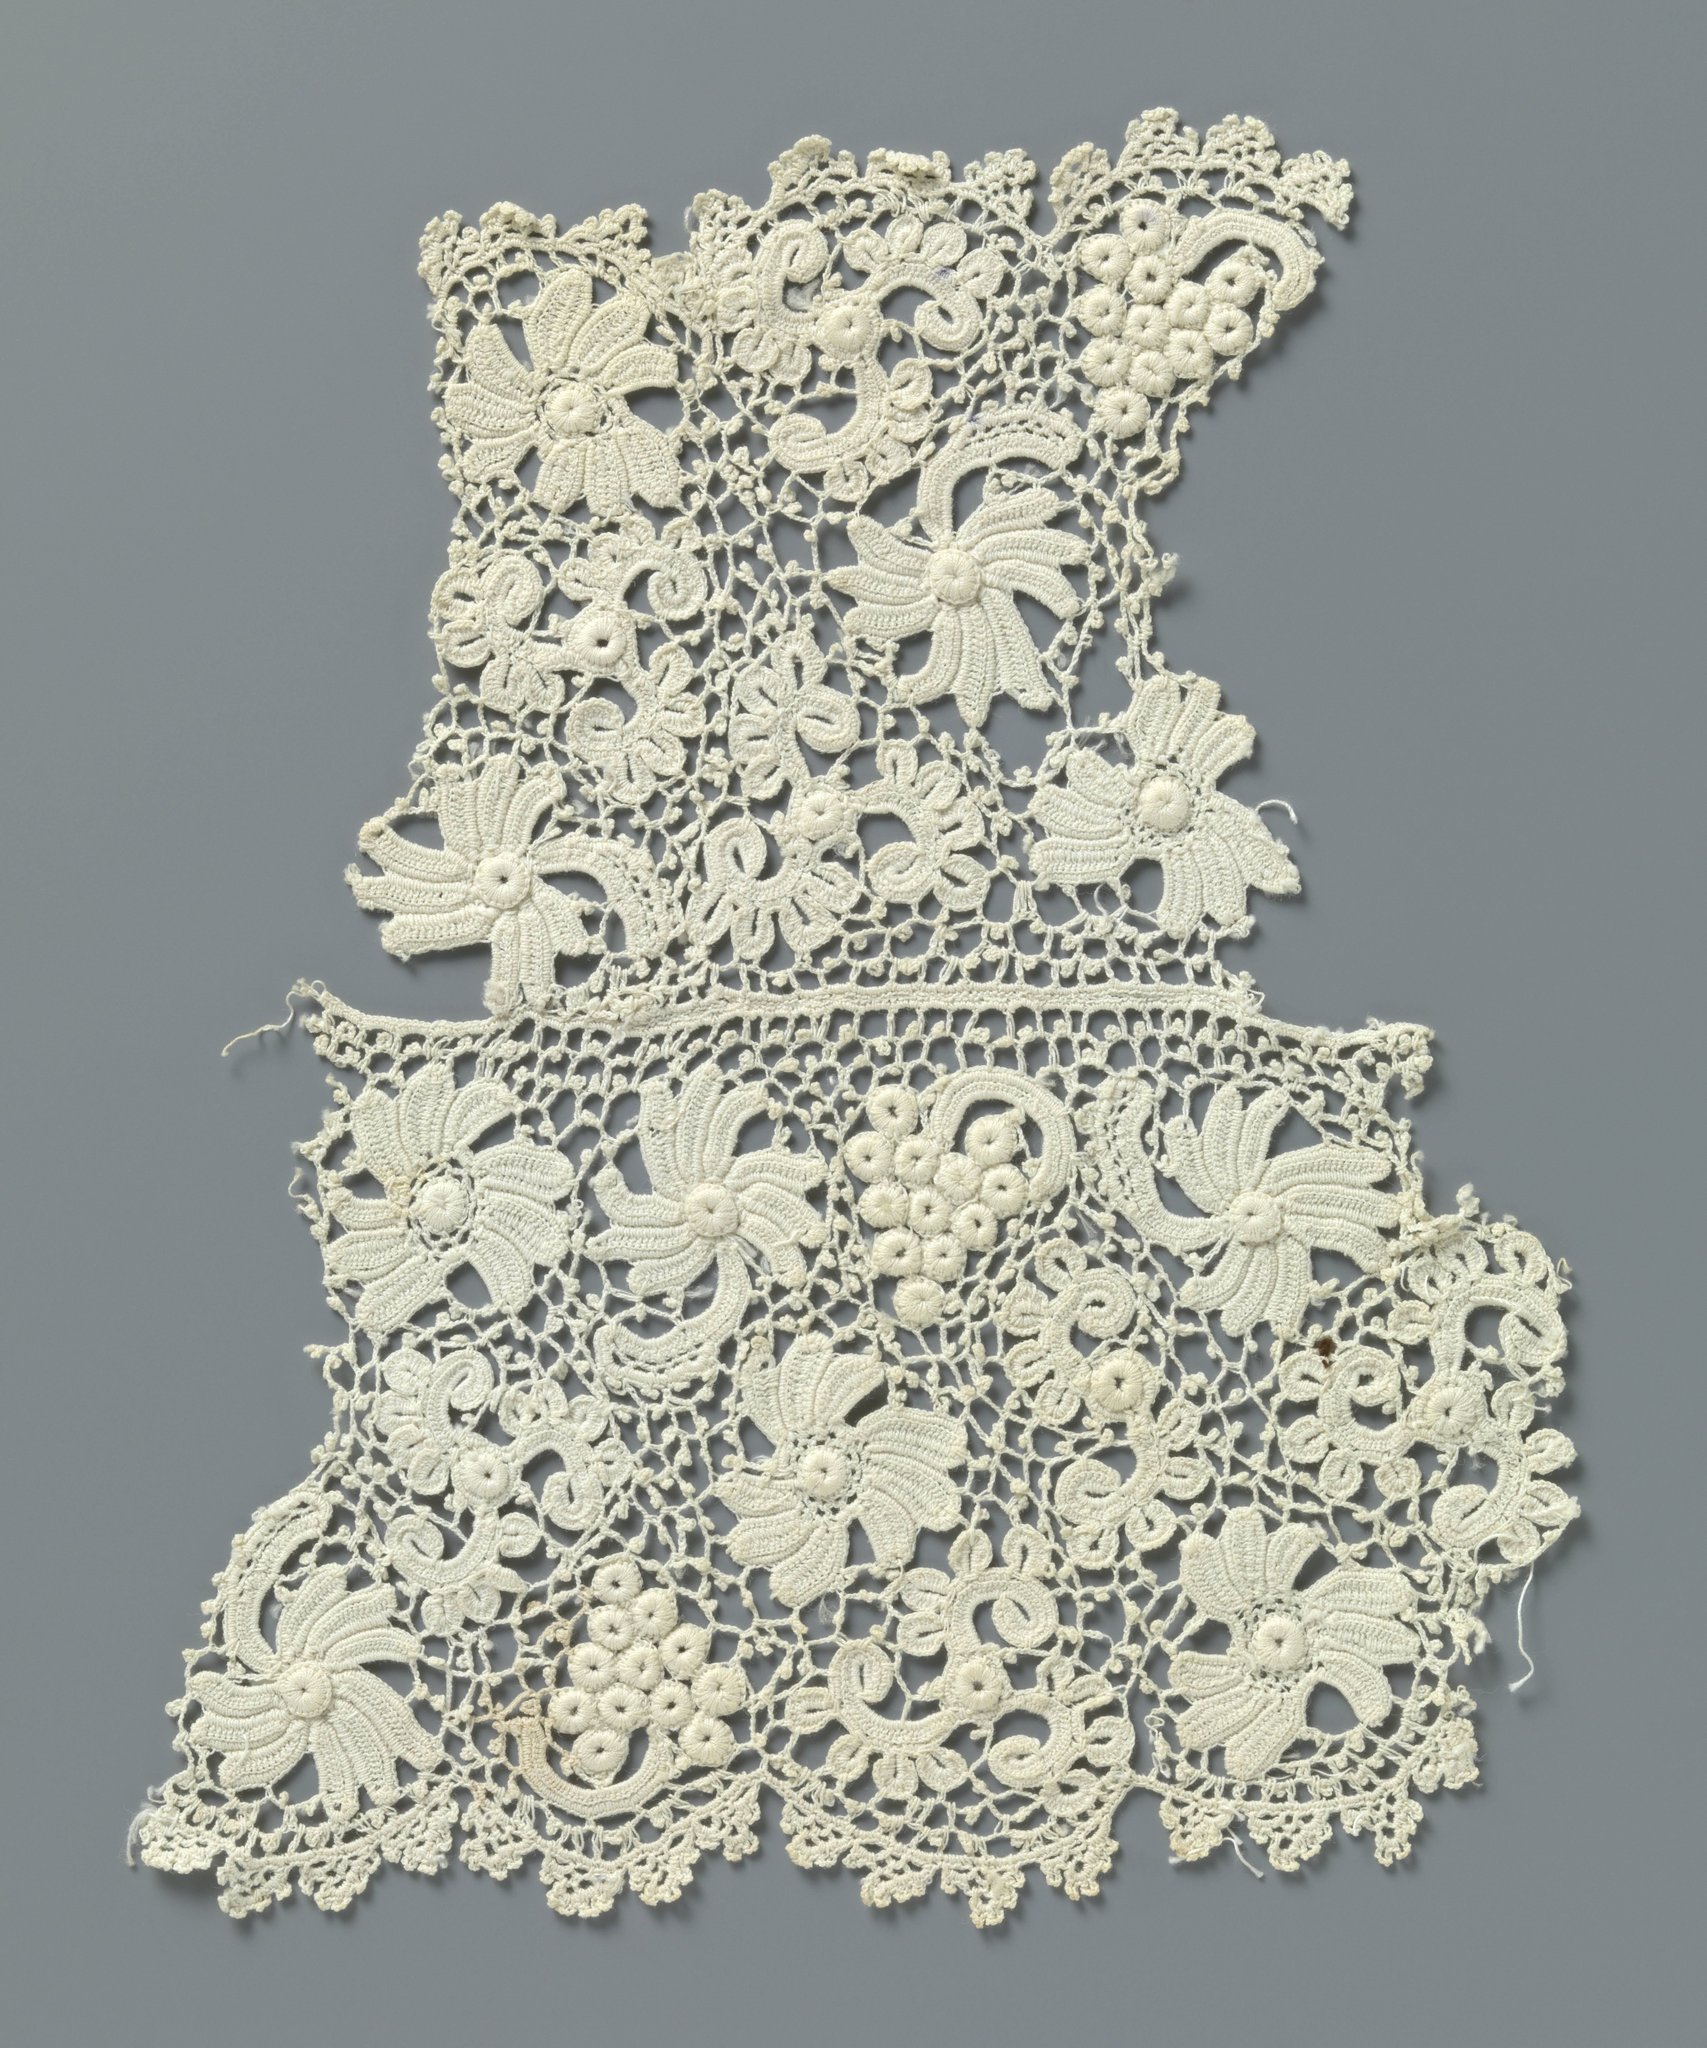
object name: strip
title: Dubbele strook gehaakte kant met bloemen en druiventros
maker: Anonymous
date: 1890-1909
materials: cotton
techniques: crocheted lace, irish crochet lace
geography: ireland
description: Het is een aanname dat deze Ierse gehaakte kant ook daadwerkelijk in Ierland is gemaakt. Ierse gehaakte kant kent zijn oorsprong rond 1760 en kwam vanaf 1840 in ontwikkeling. Aangezien volgens Martine Bruggeman (Kant in Europa) de Ierse haakindustrie aan het eind van de 19e eeuw gereorganiseerd werd en in populariteit groeide, is het hier beschreven stuk gedateerd rond 1890, tot 1909 vanwege de datering in het eerste decennium van populariteit van Ierse gehaakte kant volgens het Kantlexicon (Johan Coene).